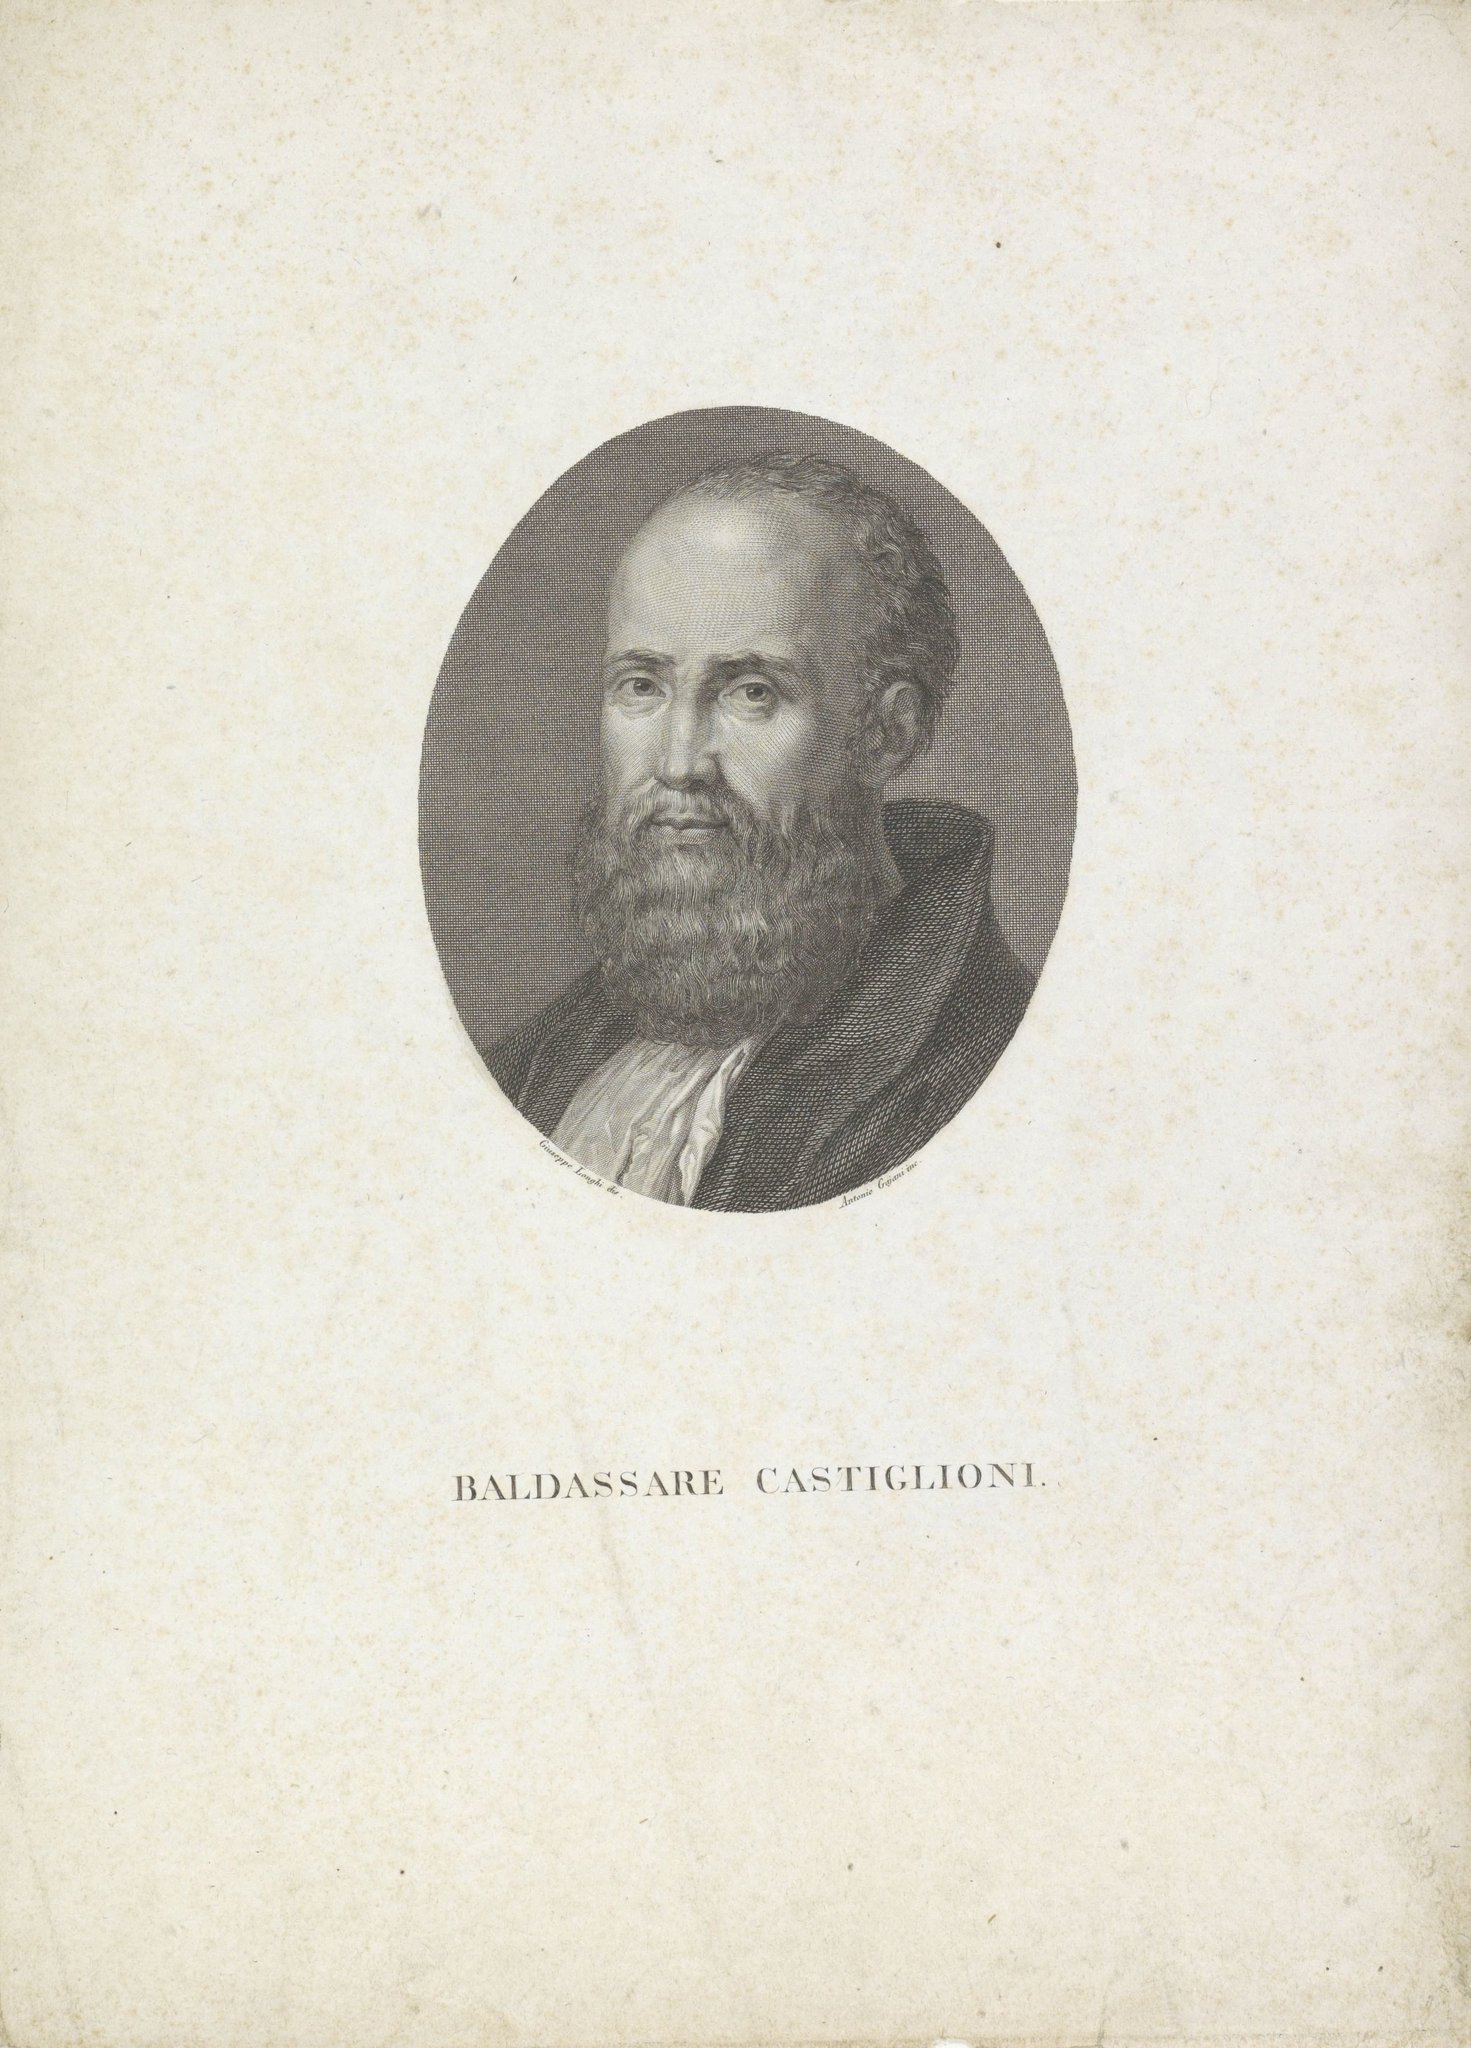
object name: print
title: Portret van dichter Baldassare Castiglioni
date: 1814-1821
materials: paper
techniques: engraving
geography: italy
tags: historical persons, portrait of a writer, writer, poet, author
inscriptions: collector's mark: Lugt 2228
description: Deze prent maakt deel uit van een reeks portretprenten van onbekende omvang. De reeks is in meerdere staten uitgegeven. De eerste staat met enkel het portret in ovaal. Een tweede staat met naam van de geportretteerde in holle letters onder de voorstelling. Een derde staat met de naam van de geportretteerde in gevulde letters onder de voorstelling. En een vierde staat met een rechthoekig kader rondom het ovale portret.